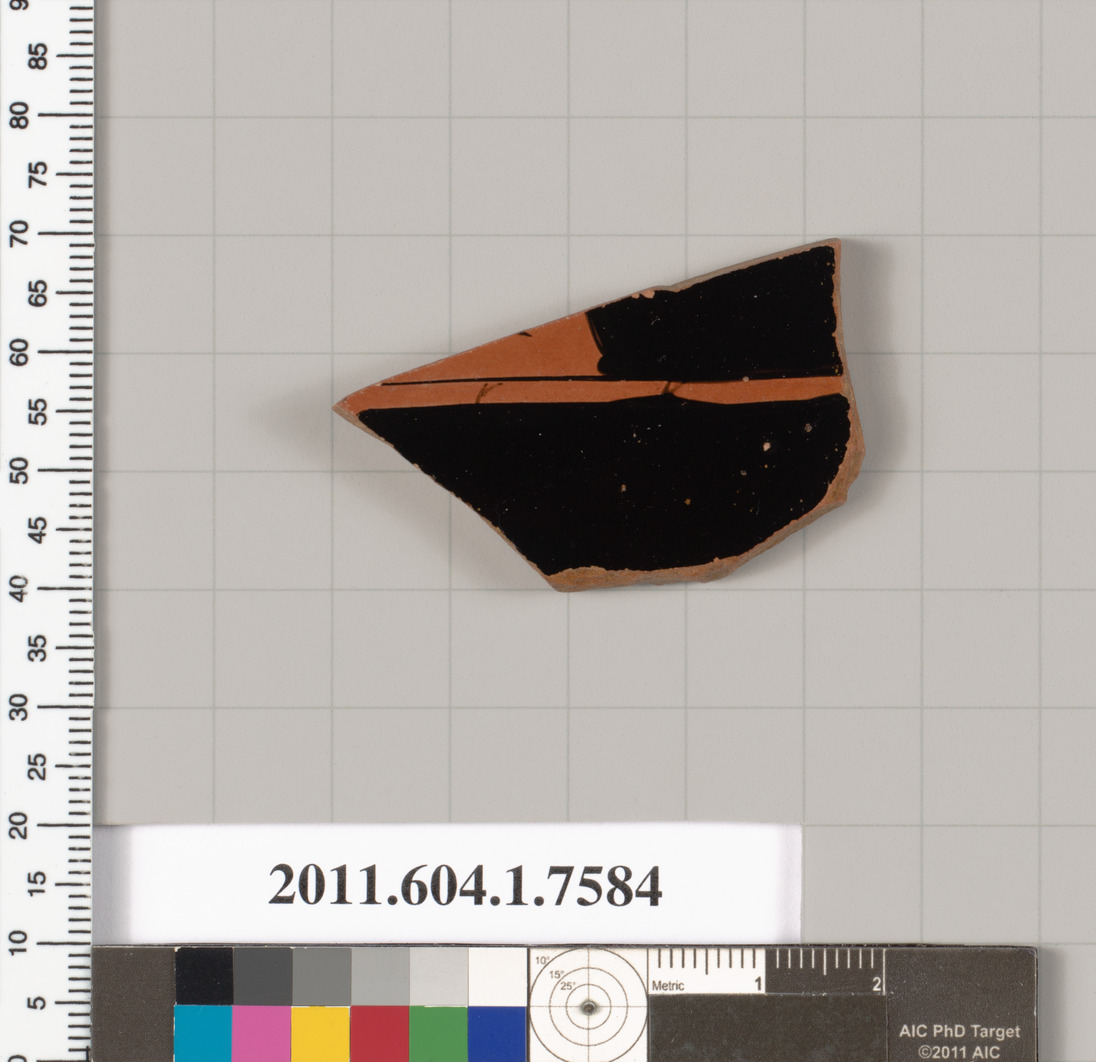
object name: kylix fragment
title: Terracotta fragment of a kylix (drinking cup)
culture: greek, attic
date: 460-450 BCE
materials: terracotta